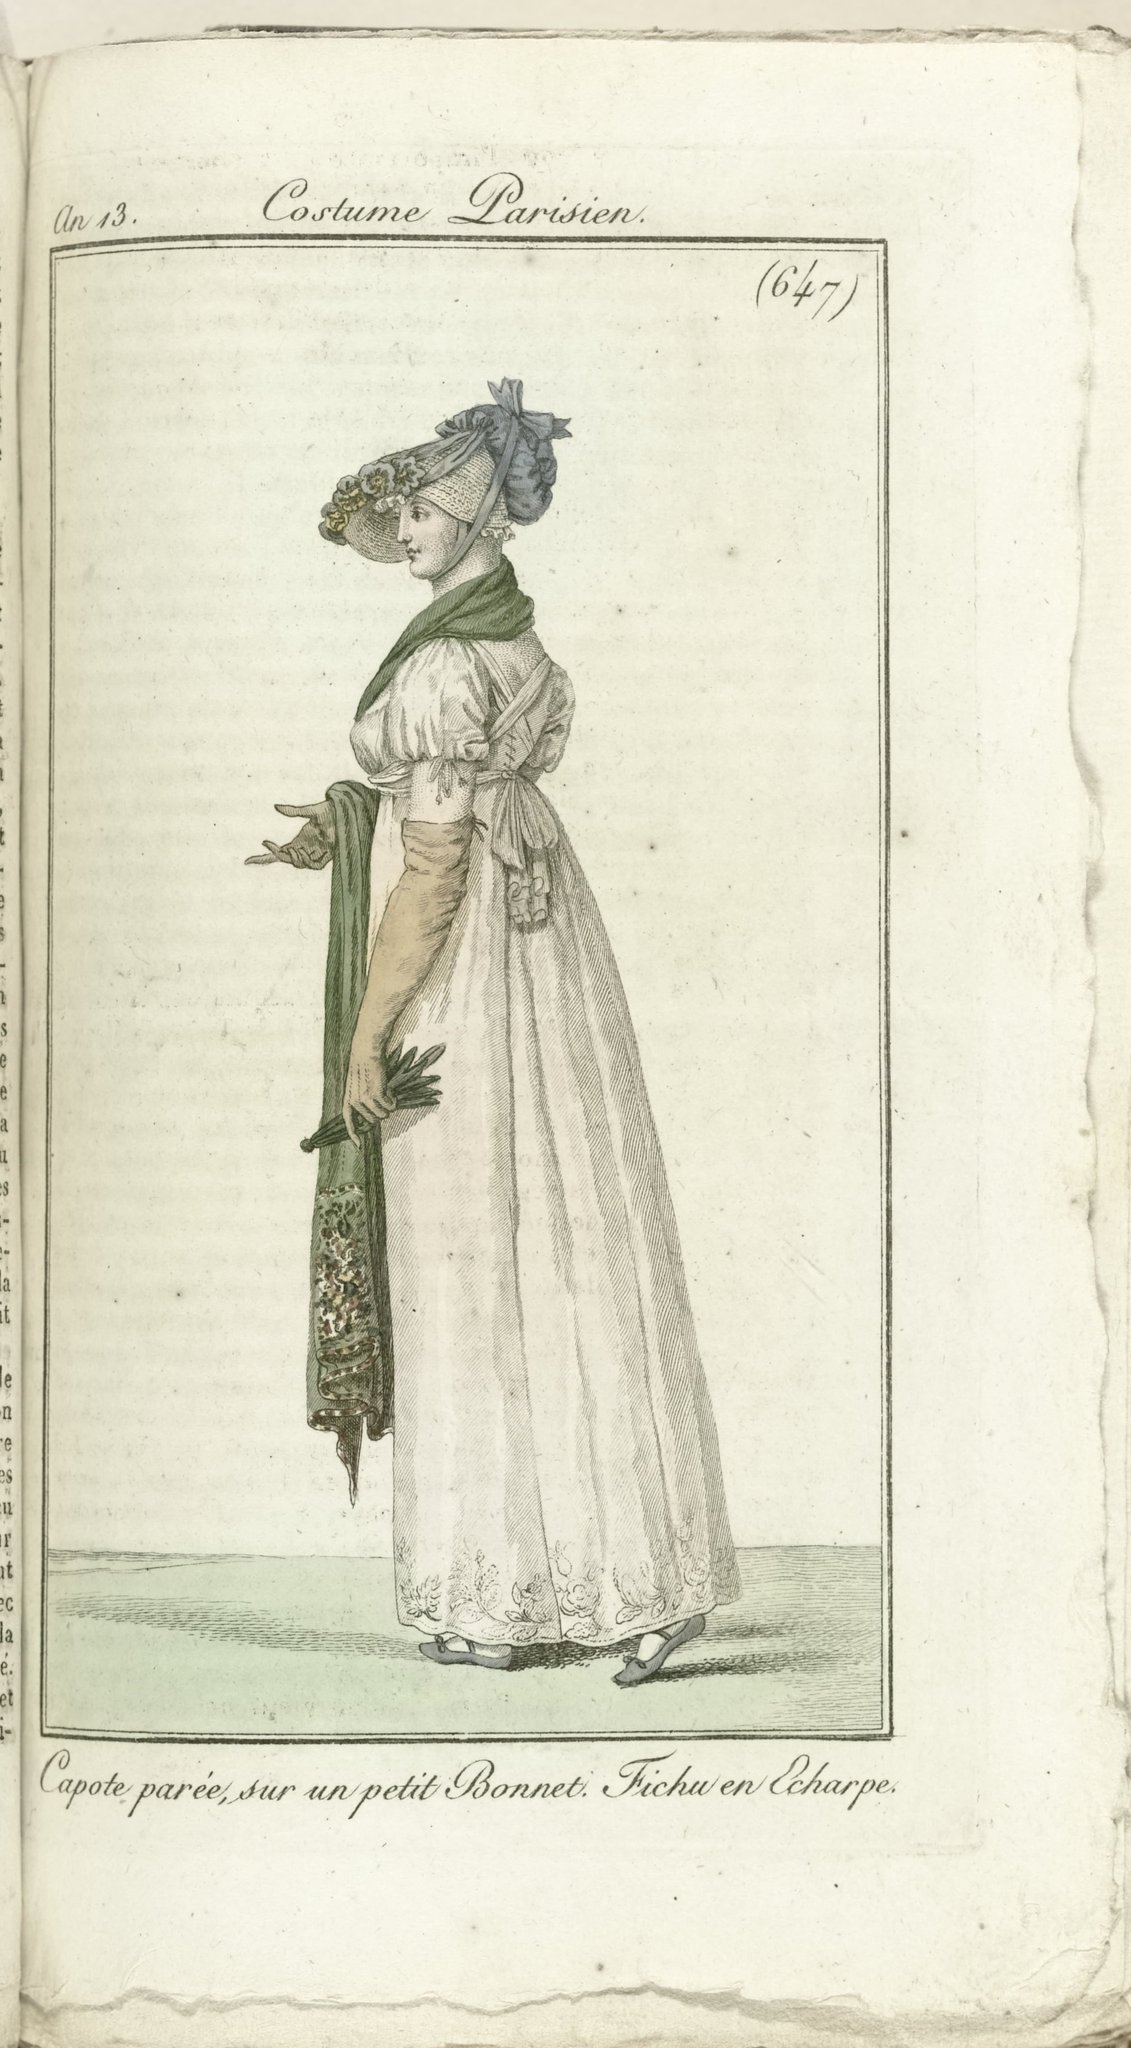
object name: fashion print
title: Journal des Dames et des Modes, Costume Parisien, 1805, An 13 (647) Capote parée, sur un petit Bonnet...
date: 1805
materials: paper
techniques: engraving, hand coloring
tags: head-gear (capote) (+ women's clothes), gloves, mittens (long gloves) (+ women's clothes), neck-gear ~ clothing (shawl) (+ women's clothes), head-gear (+ women's clothes), head-gear (bonnet) (+ women's clothes), fashion plates, fan (+ women's clothes), piece of clothing covering the breast or décolleté (fichu) (+ women's clothes)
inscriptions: title: ‘Capote parée, sur un petit Bonnet. Fichu en Echarpe.’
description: Vrouw naar links, in witte japon met korte pofmouwen en een lijfje met kruisbanden op de rug. Versierde capote over een kleine bonnet. Lange handschoenen. Over de rechterarm een lange groene sjaal met borduursel, in de andere hand een dichtgevouwen waaier.